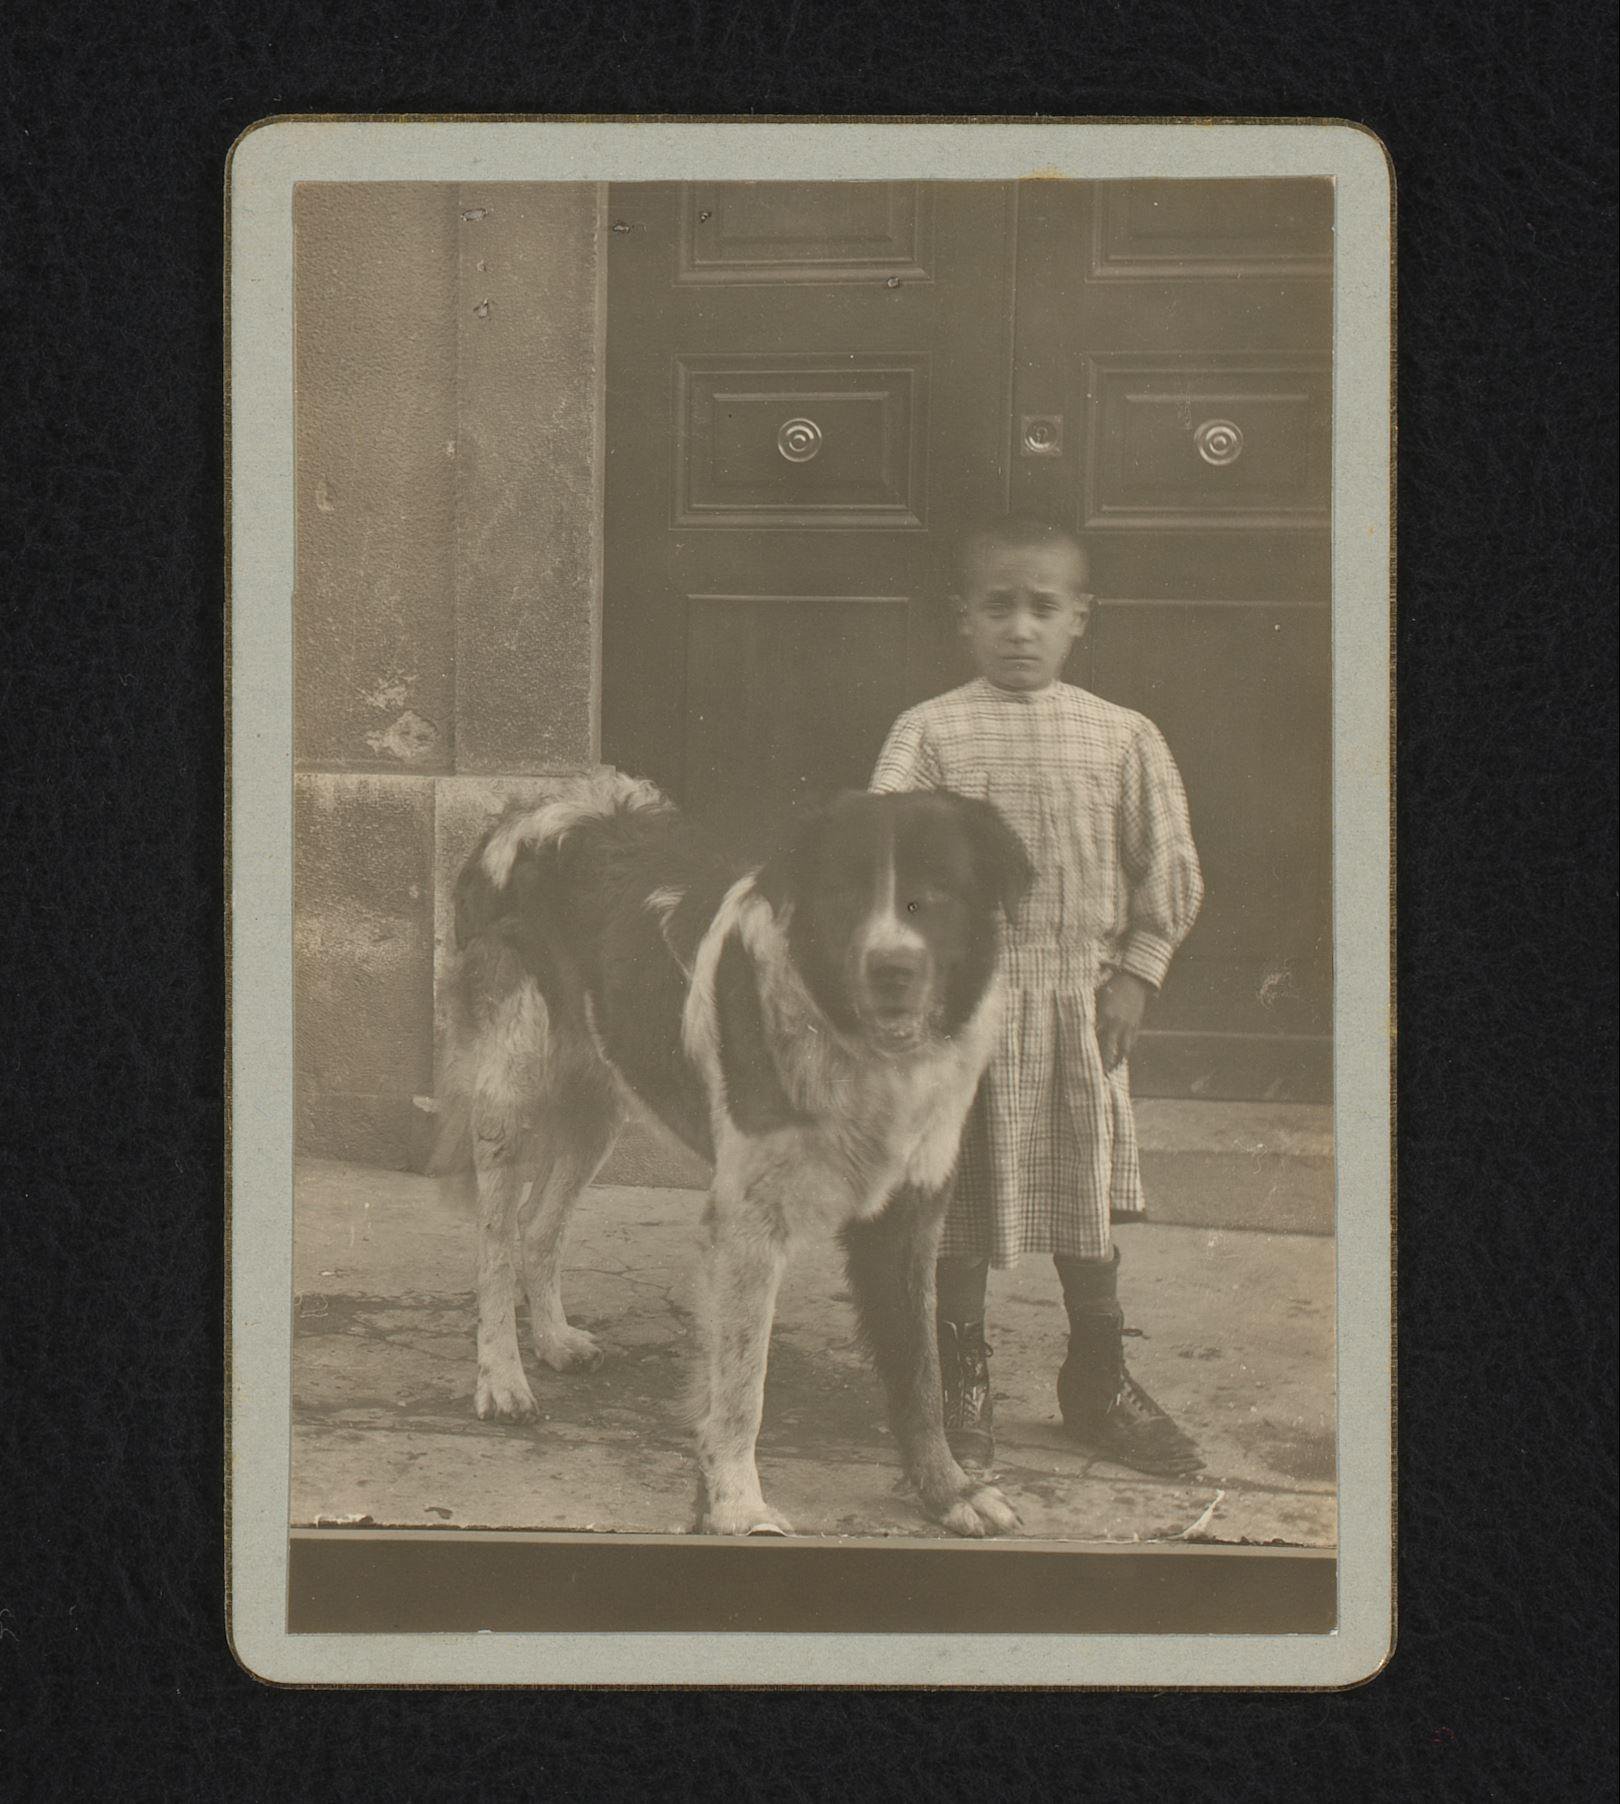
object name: photograph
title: Portret van een jongen met hond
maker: Anonymous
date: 1890-1920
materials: cardboard, photographic support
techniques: gelatin silver print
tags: boy (child between toddler and youth), dog